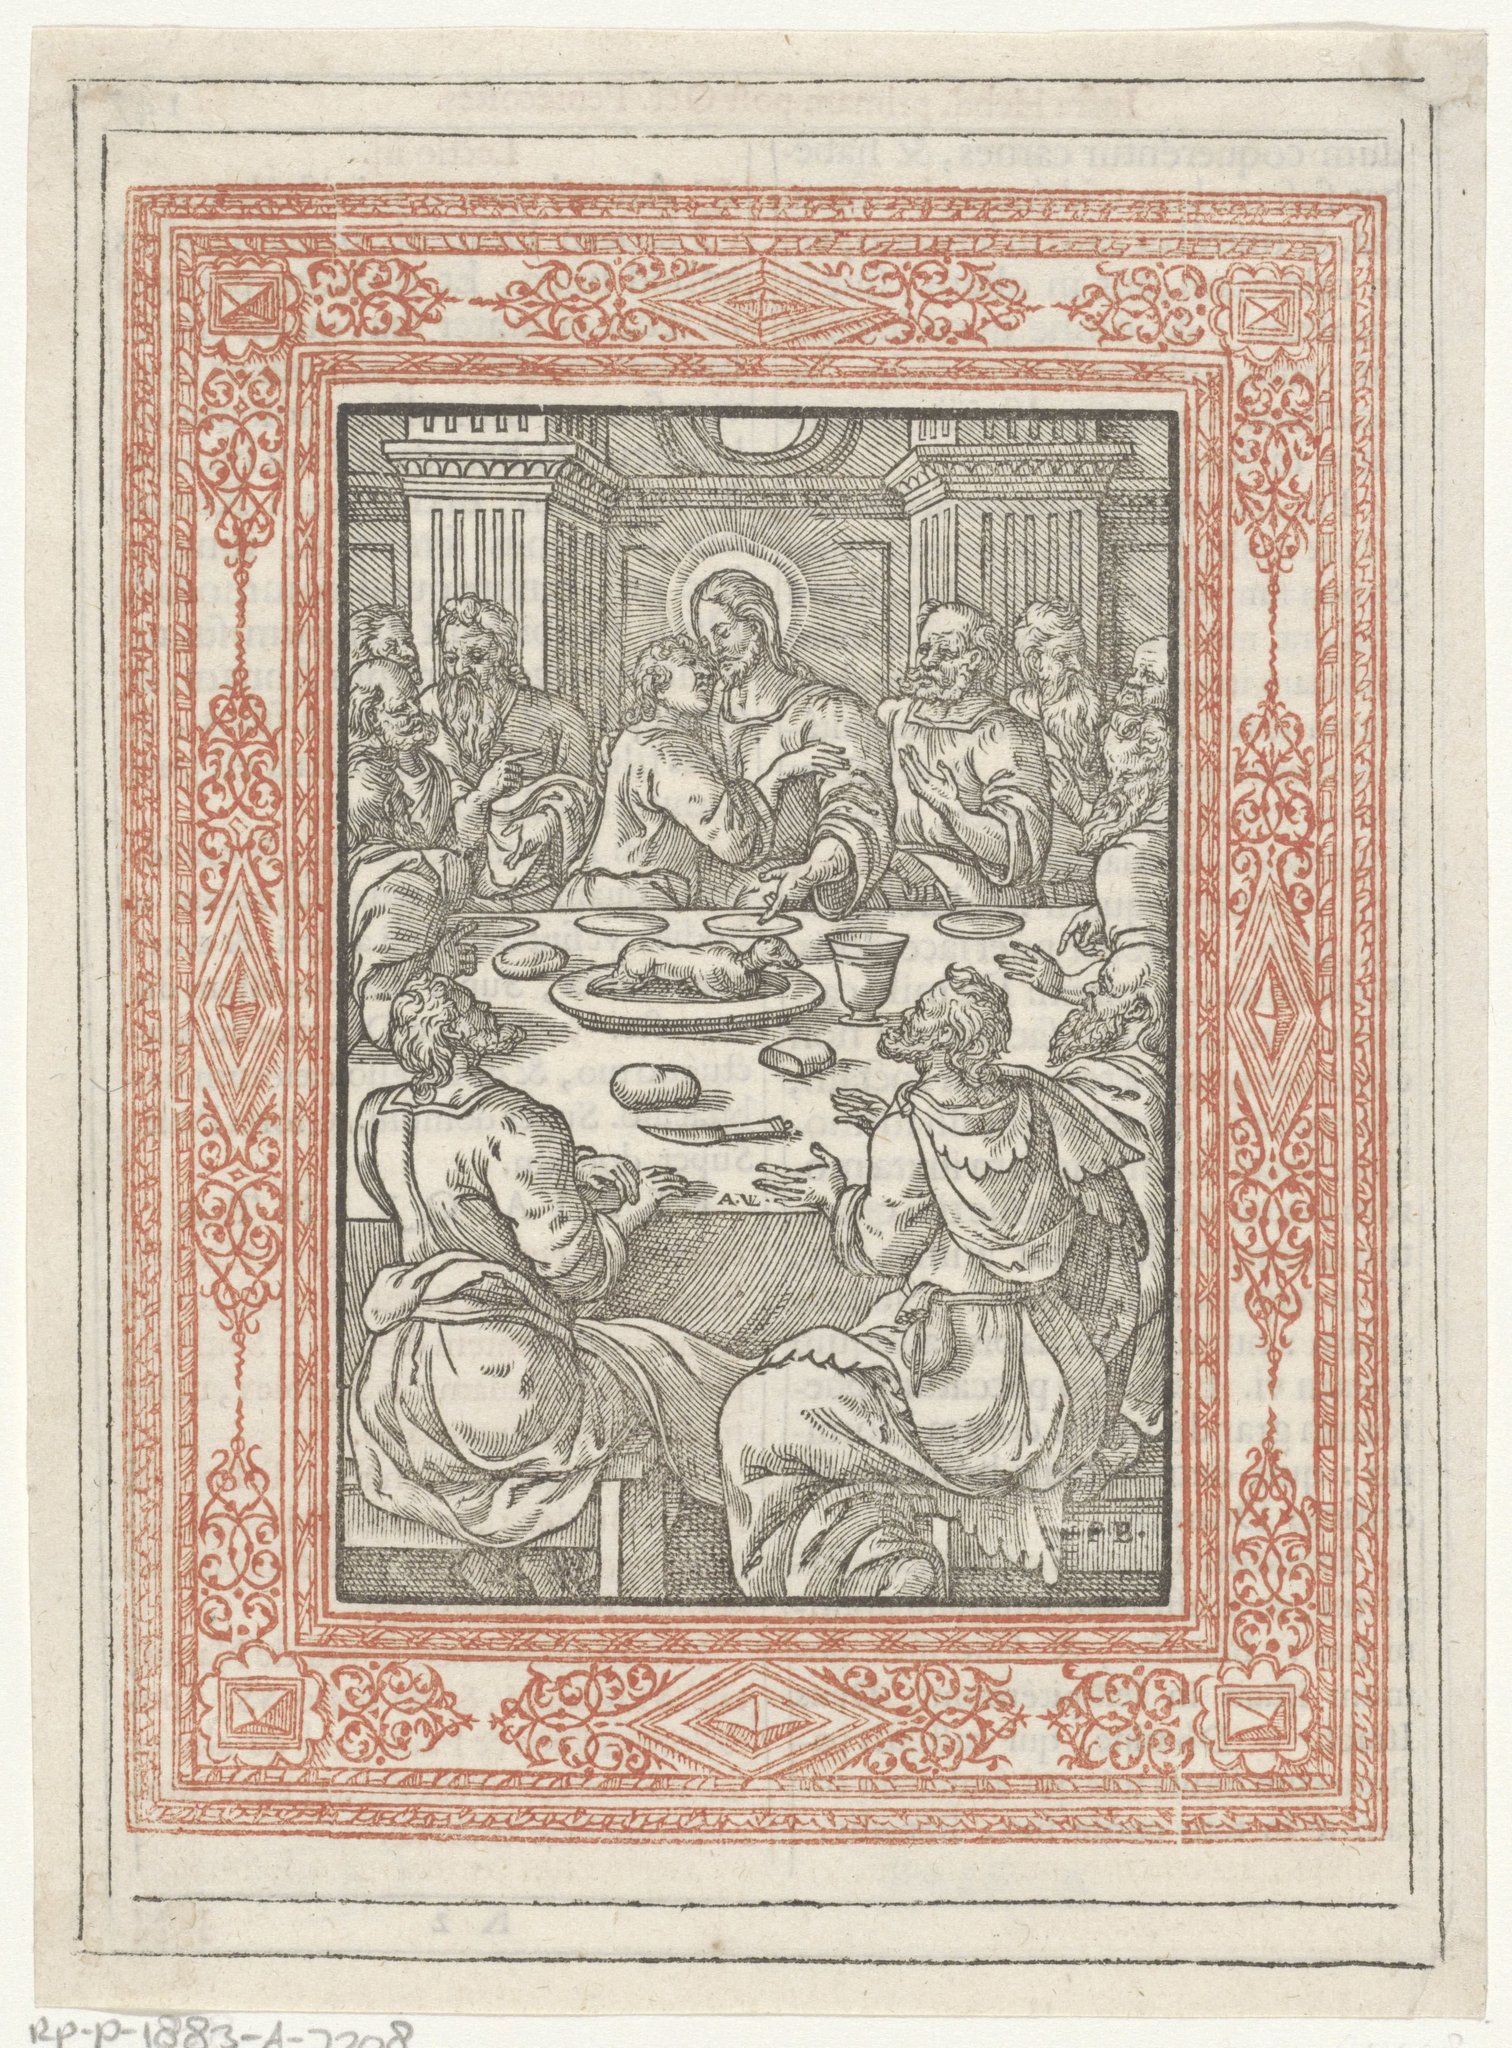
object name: print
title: Laatste avondmaal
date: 1574-1632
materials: paper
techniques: letterpress printing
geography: antwerp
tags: last supper (in general) (matthew 26:21-35; mark 14:18-31; luke 22:3, 22:15-23; john 13:21-38)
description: Christus zit tijdens het laatste avondmaal te midden van zijn discipelen. Johannes ligt tegen zijn borst. Geheel in een geornamenteerde omlijsting.